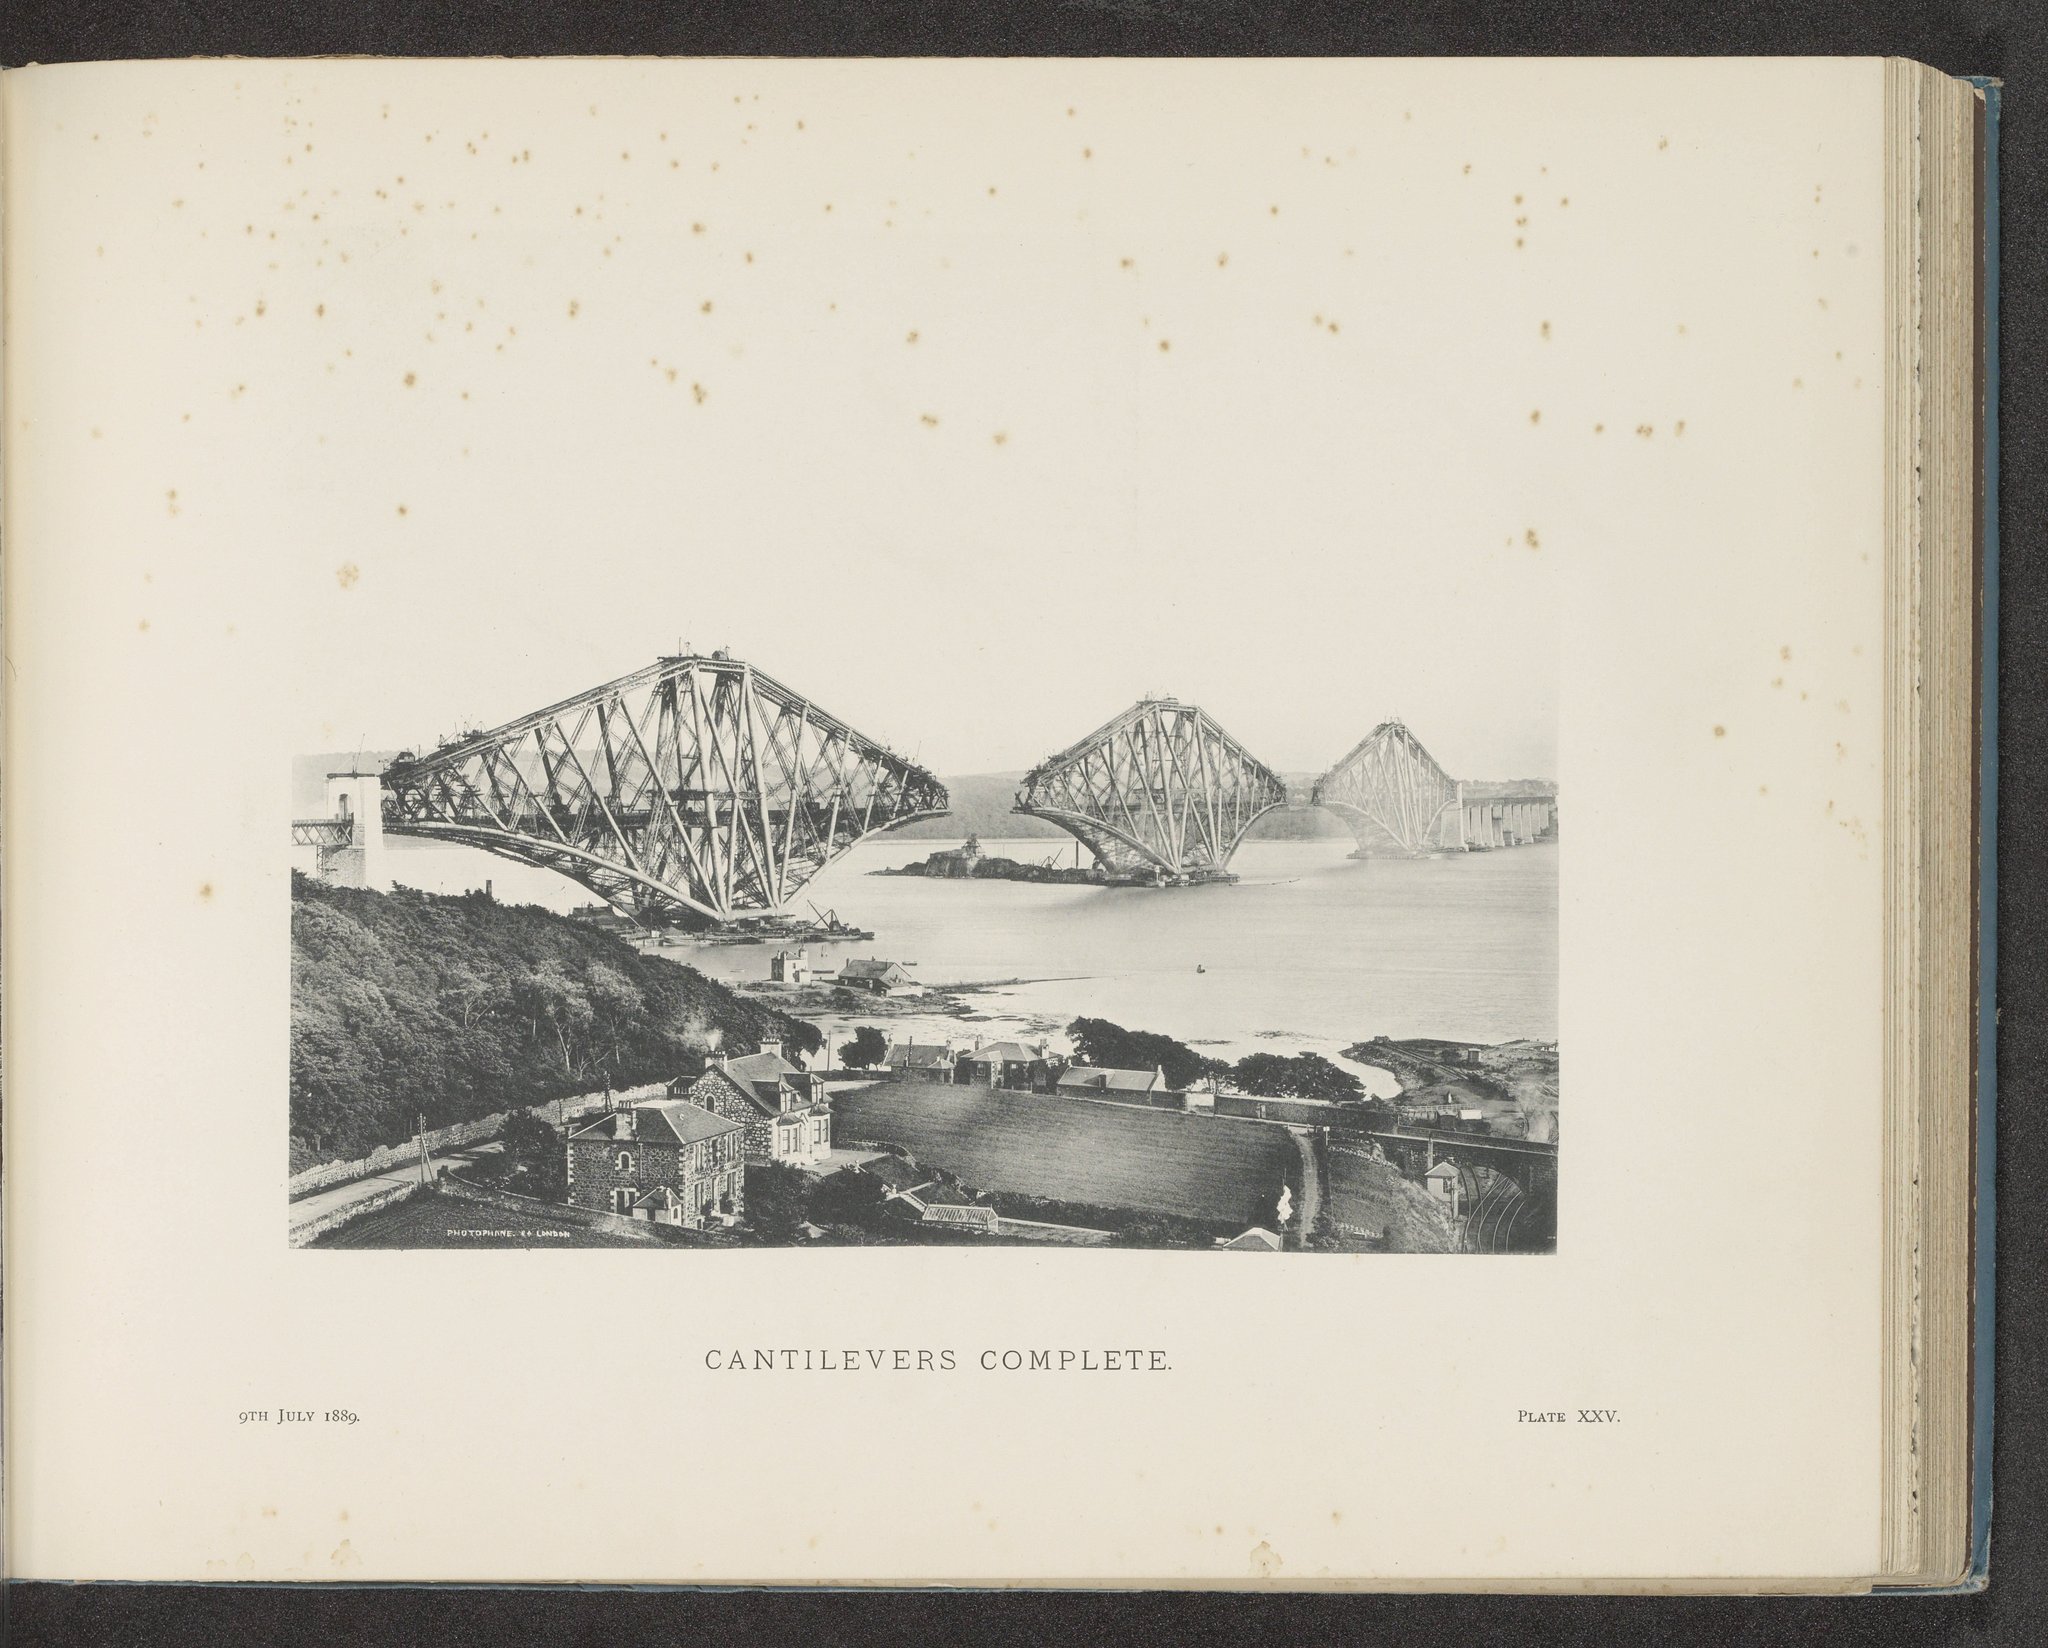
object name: photomechanical print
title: Cantilevers complete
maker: Anonymous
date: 1889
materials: paper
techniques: photograph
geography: london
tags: building materials, landscape with bridge, viaduct or aqueduct, bridge, building-site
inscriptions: number: ‘Plate XXV.’